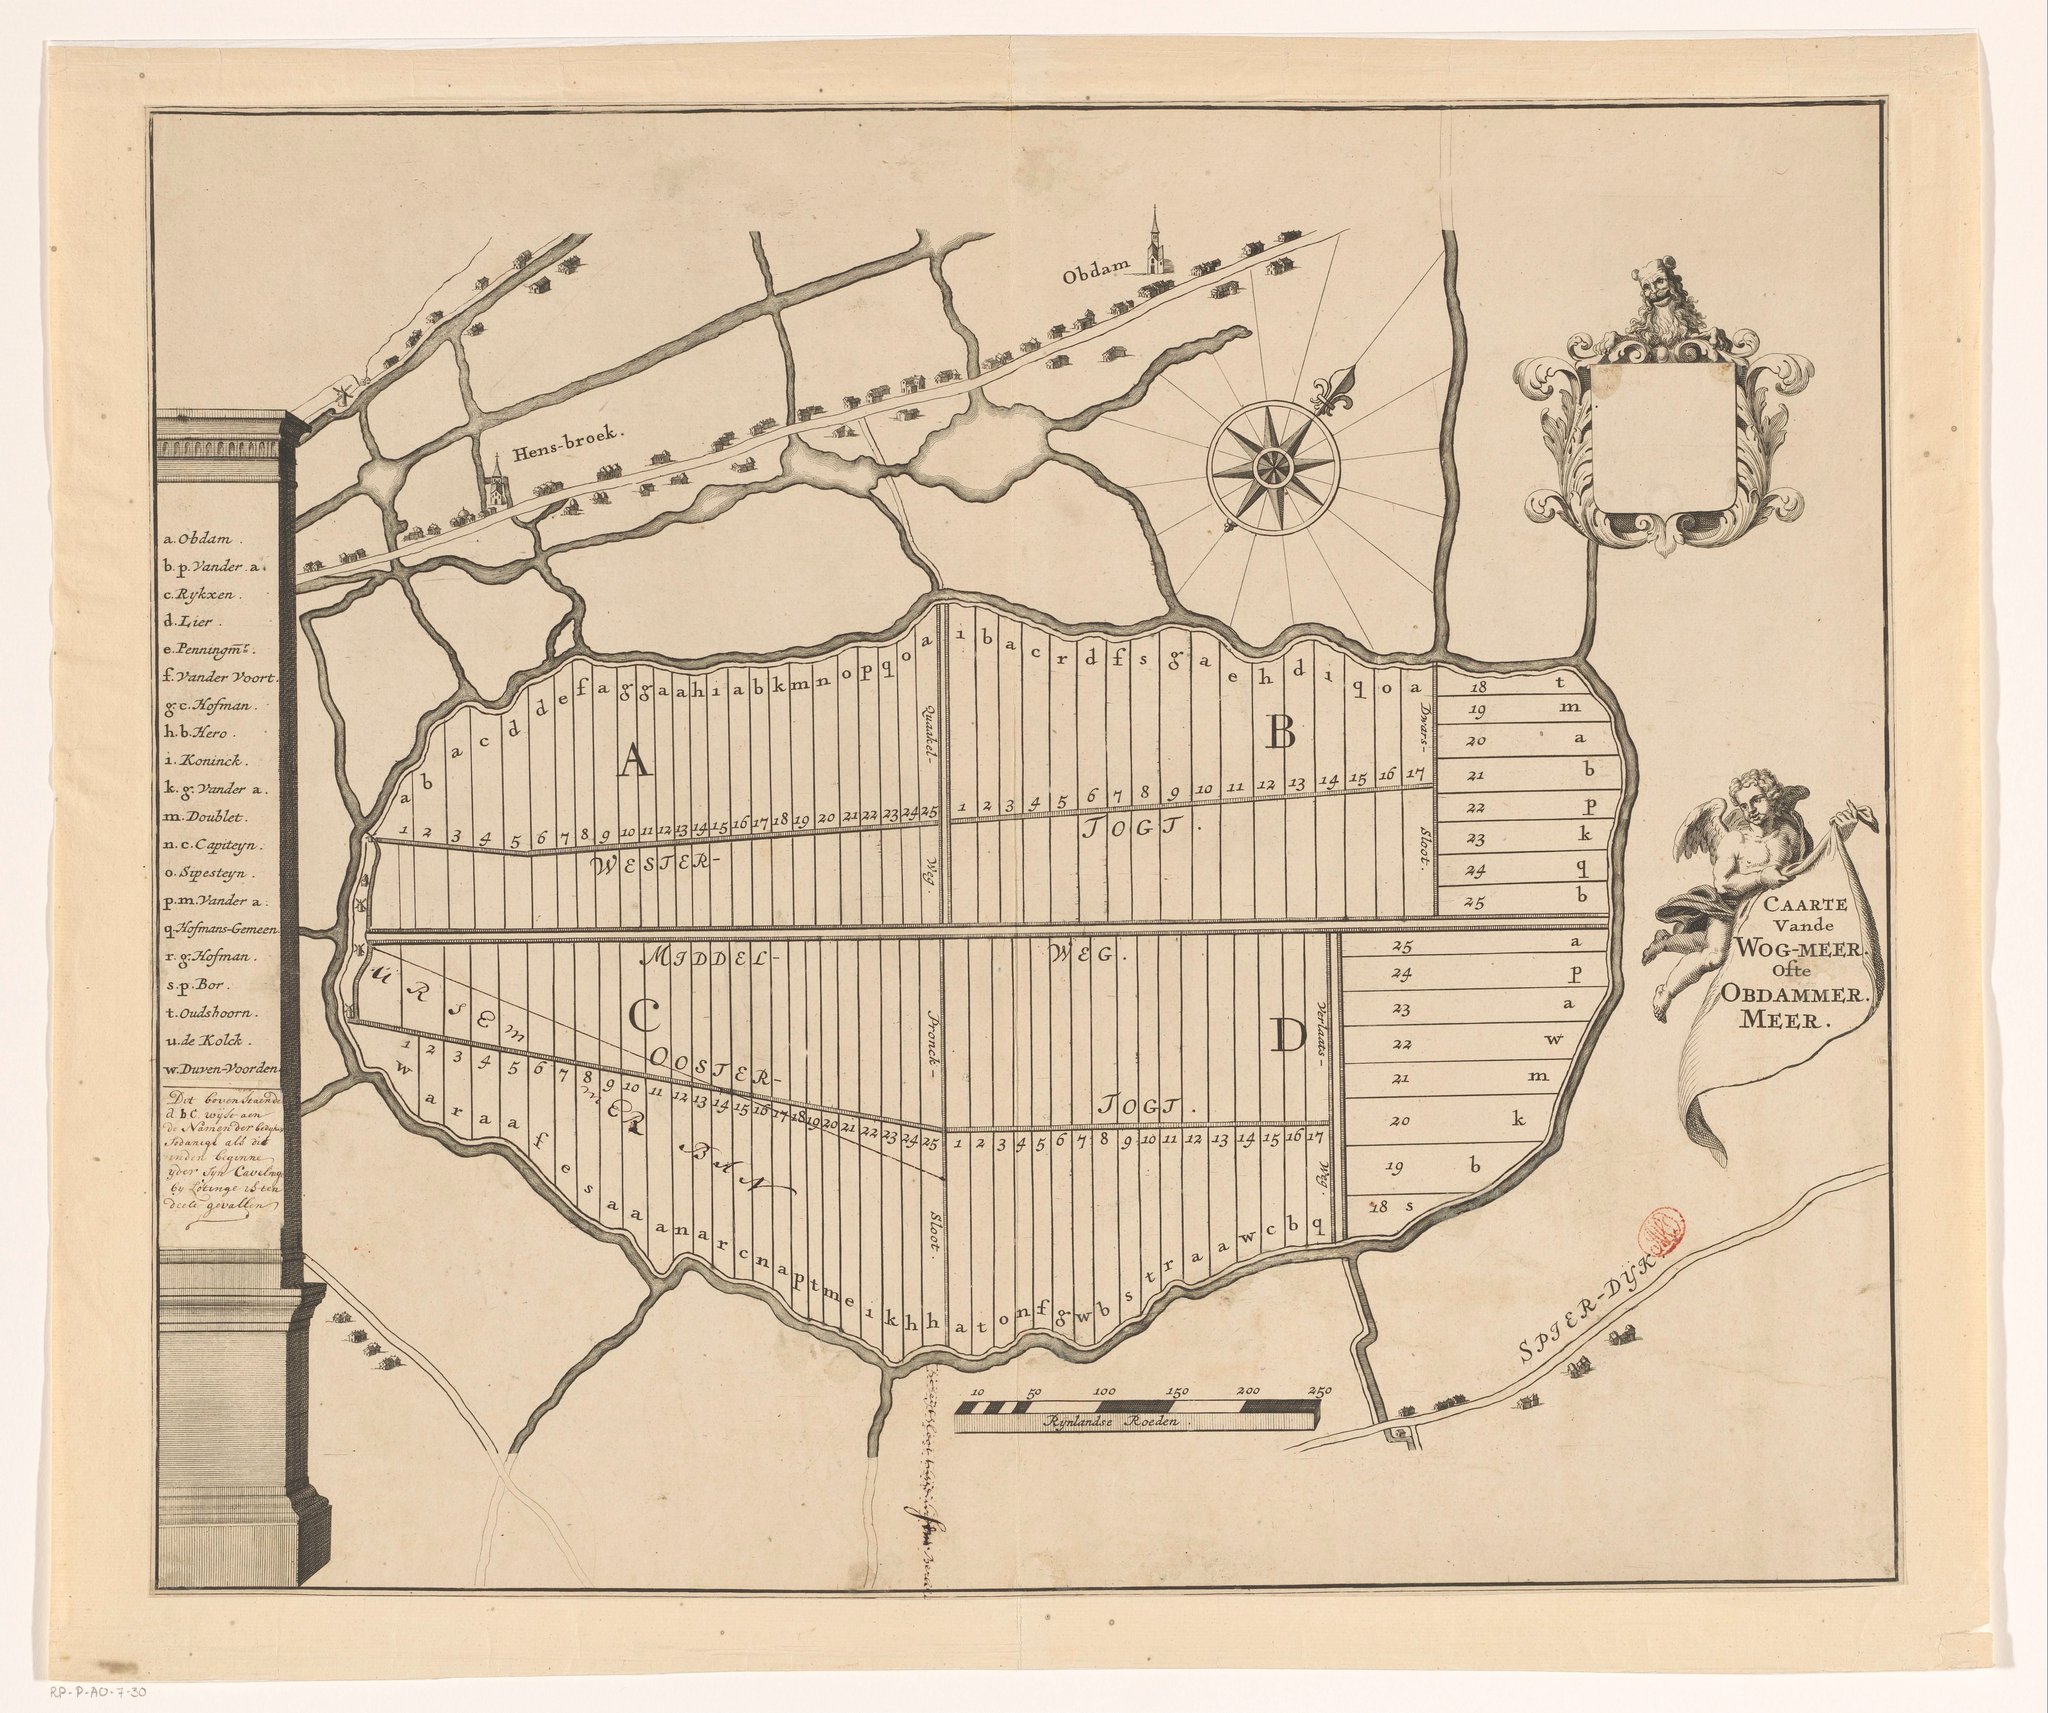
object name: print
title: Kaart van de verkaveling van de polder Wogmeer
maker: albert schut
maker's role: print maker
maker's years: 1687-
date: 1717-1718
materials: ink, paper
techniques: engraving, etching, pen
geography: amsterdam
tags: maps of separate countries or regions, polder, reclaimed land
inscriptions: inscription: ‘Dit bovenstaende A.B.C. wijst aen de namen der bedijkers sodanigh als die inden beginne yder sijn cavelinge by lotinge is ten deele gevallen Scheijtsloot tussen Ursem [en] Berk[meer?]’, collector's mark: Lugt 195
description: Ondanks het feit dat het kaartbeeld en de verdeling van de kavels de situatie van vlak na de drooglegging (1608) en verkaveling (1609) weergeeft, dateert deze kaart waarschijnlijk uit het begin van de achttiende eeuw. Het polderbestuur van de Wogmeer besloot in 1717 dat er een kaart gemaakt en gedrukt zou moeten worden en prentmaker Albert Schut kreeg de opdracht om de koperplaat hiervoor te maken (zie documentatie, artikel Jan de Bruin). Deze kaart, die verscheen in 1718 en rechtsonder Schuts naam draagt, is duidelijk een latere staat van de huidige kaart.* Onderaan is de schaalstok verwijderd en daaroverheen is een cartouche met tekst geplaatst. Links en rechts daarvan zijn landelijke taferelen toegevoegd. Rechtsboven is een nieuwe schaalstok gezet en het lege wapenschild is ingevuld. Een belangrijke aanwijzing die de veronderstelling dat de huidige kaart een proefdruk van deze kaart is versterkt, is het feit dat de handgeschreven tekst op de zuil links (‘Dit bovenstaende A.B.C. wijst aen…’), ook op de kaart uit 1718 staat, maar dan gegraveerd. * Voor een exemplaar van deze kaart zie Universiteitsbibliotheek Leiden, collectie Bodel Nijenhuis, COLLBN Port 31 N 28.